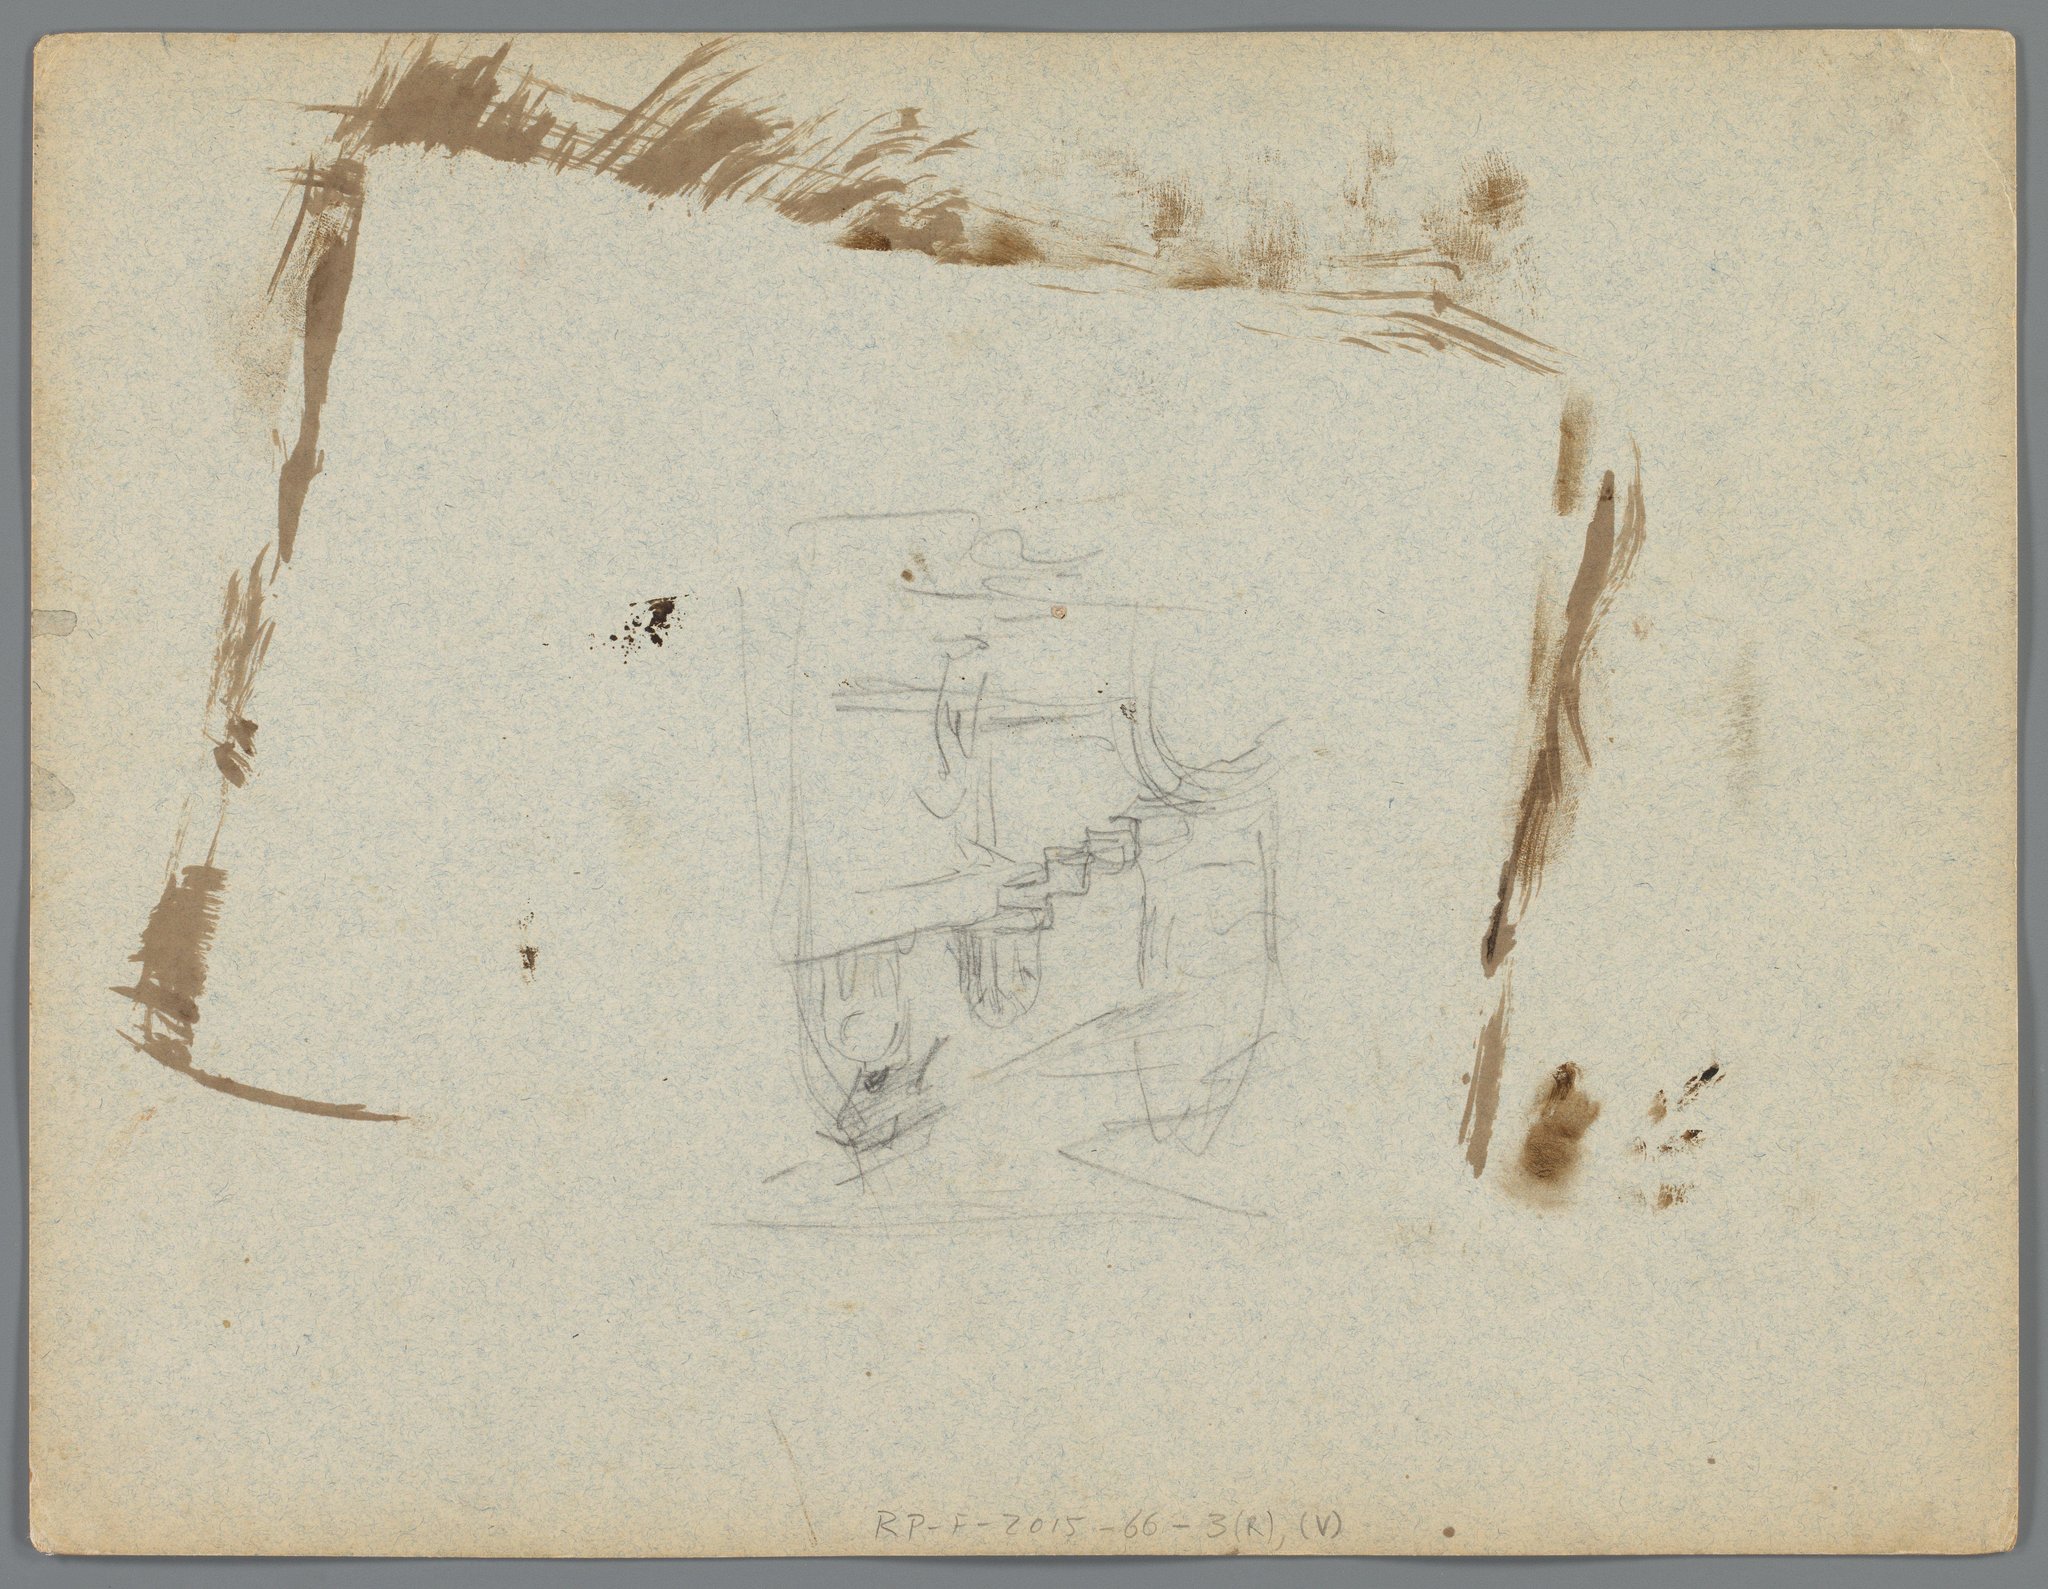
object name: drawing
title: Interieur met trap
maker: marius bauer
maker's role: draughtsman, print maker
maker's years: 1867-1932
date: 1890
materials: cardboard, pencil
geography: india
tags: interior ~ representation of a building